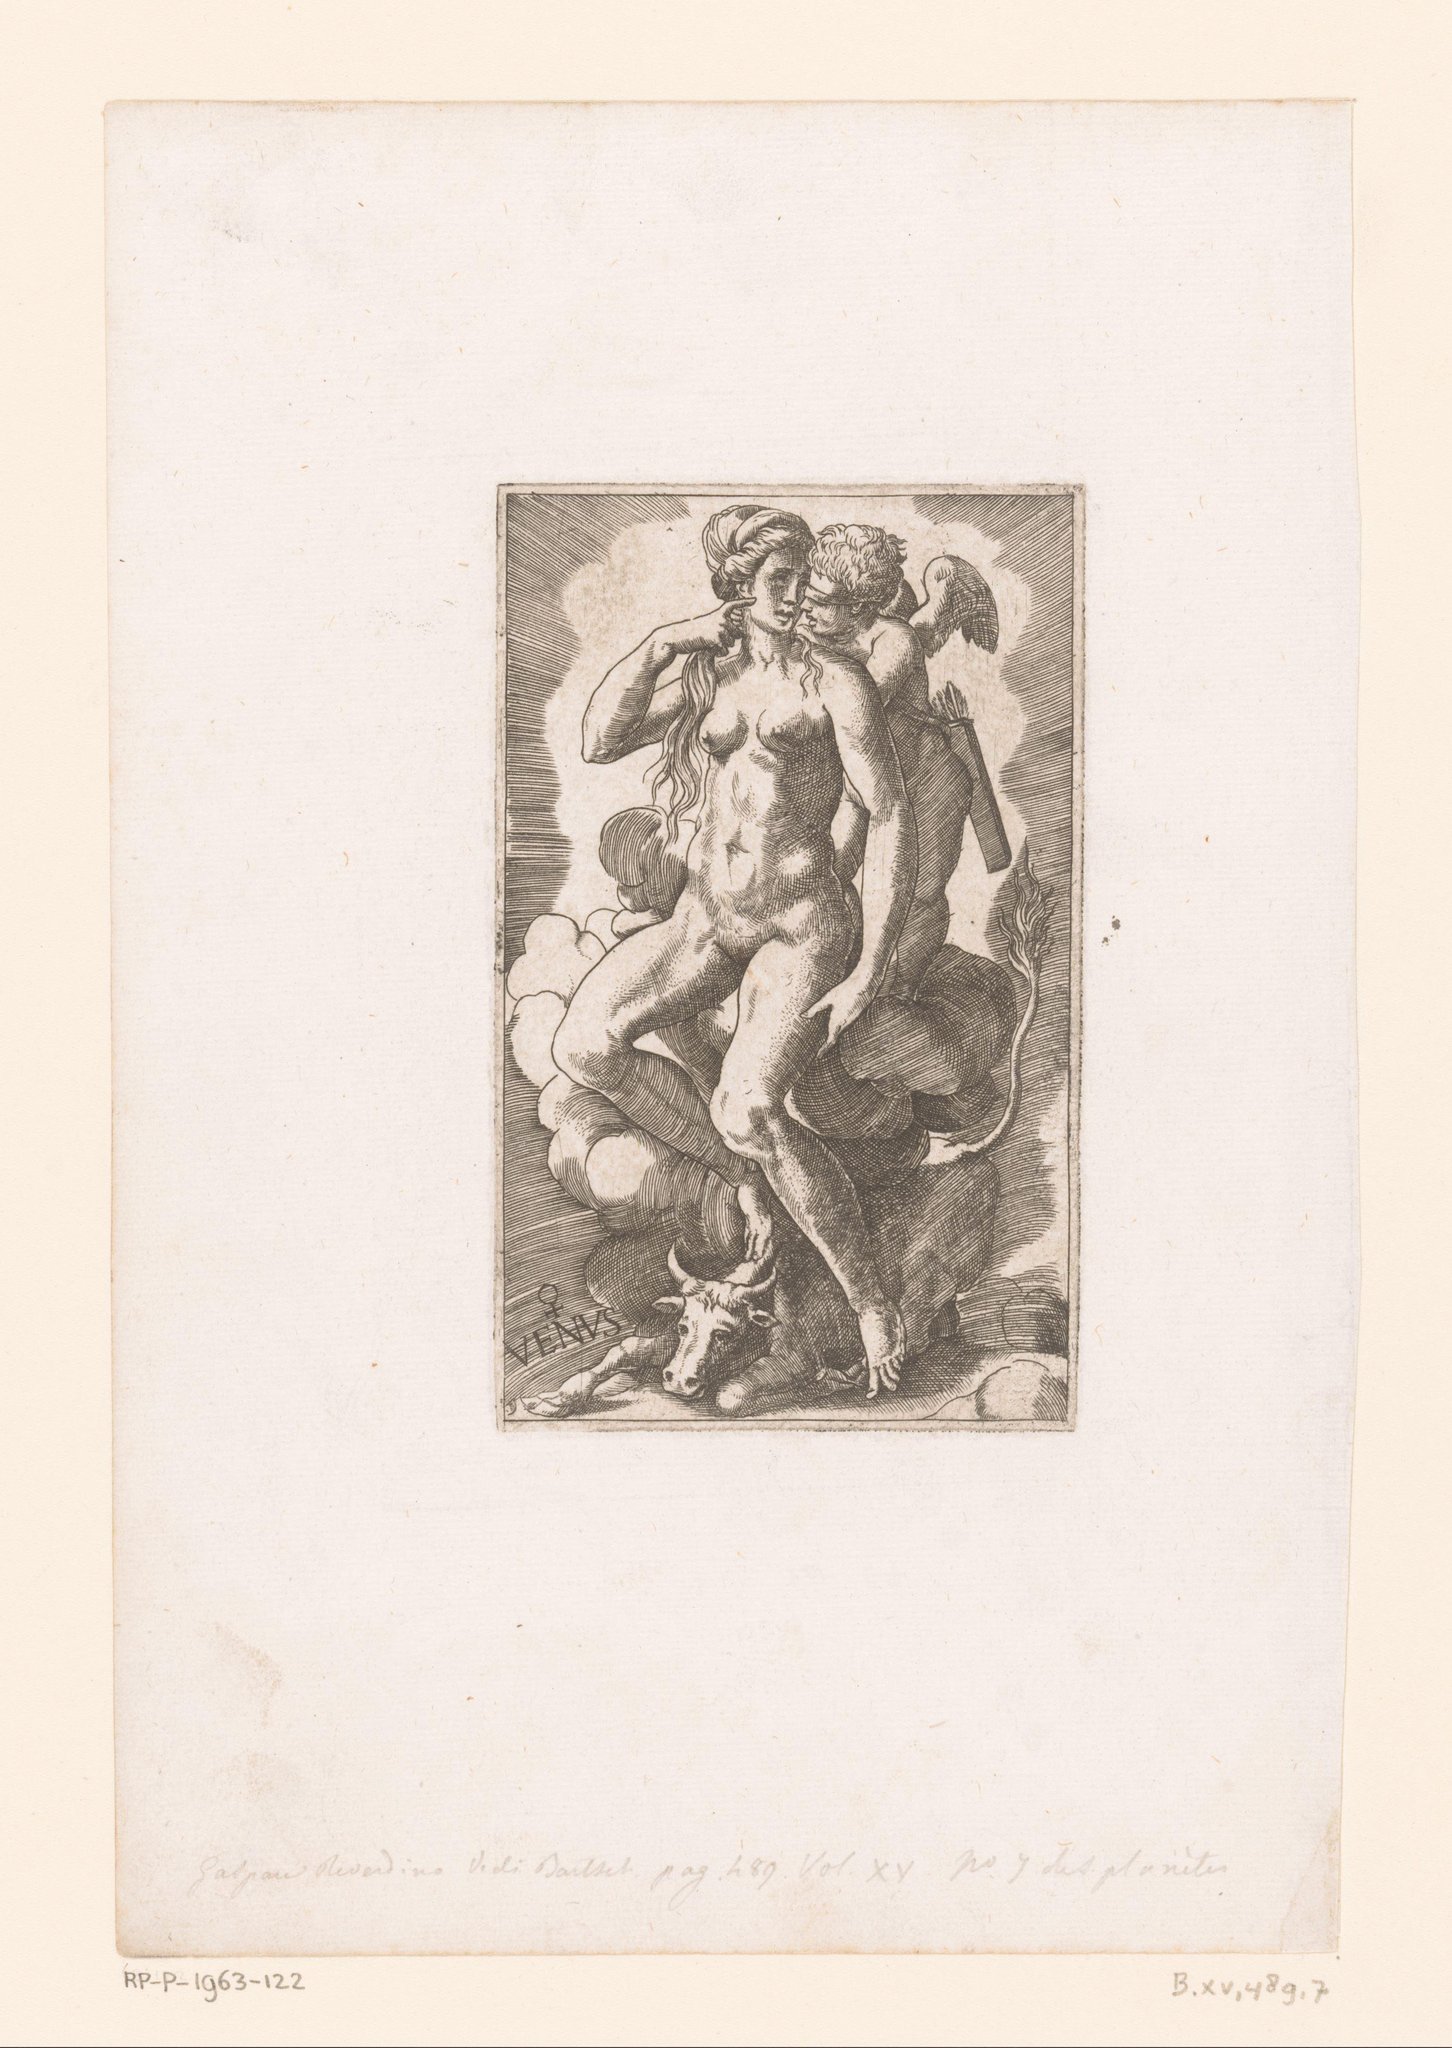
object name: print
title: Venus met geblinddoekte Cupido, aan haar voeten een stier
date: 1536-1569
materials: paper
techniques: engraving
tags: (story of) venus (aphrodite), venus and her children ('planetenkinder')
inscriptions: collector's mark: Lugt 2760, collector's mark: Lugt 2228